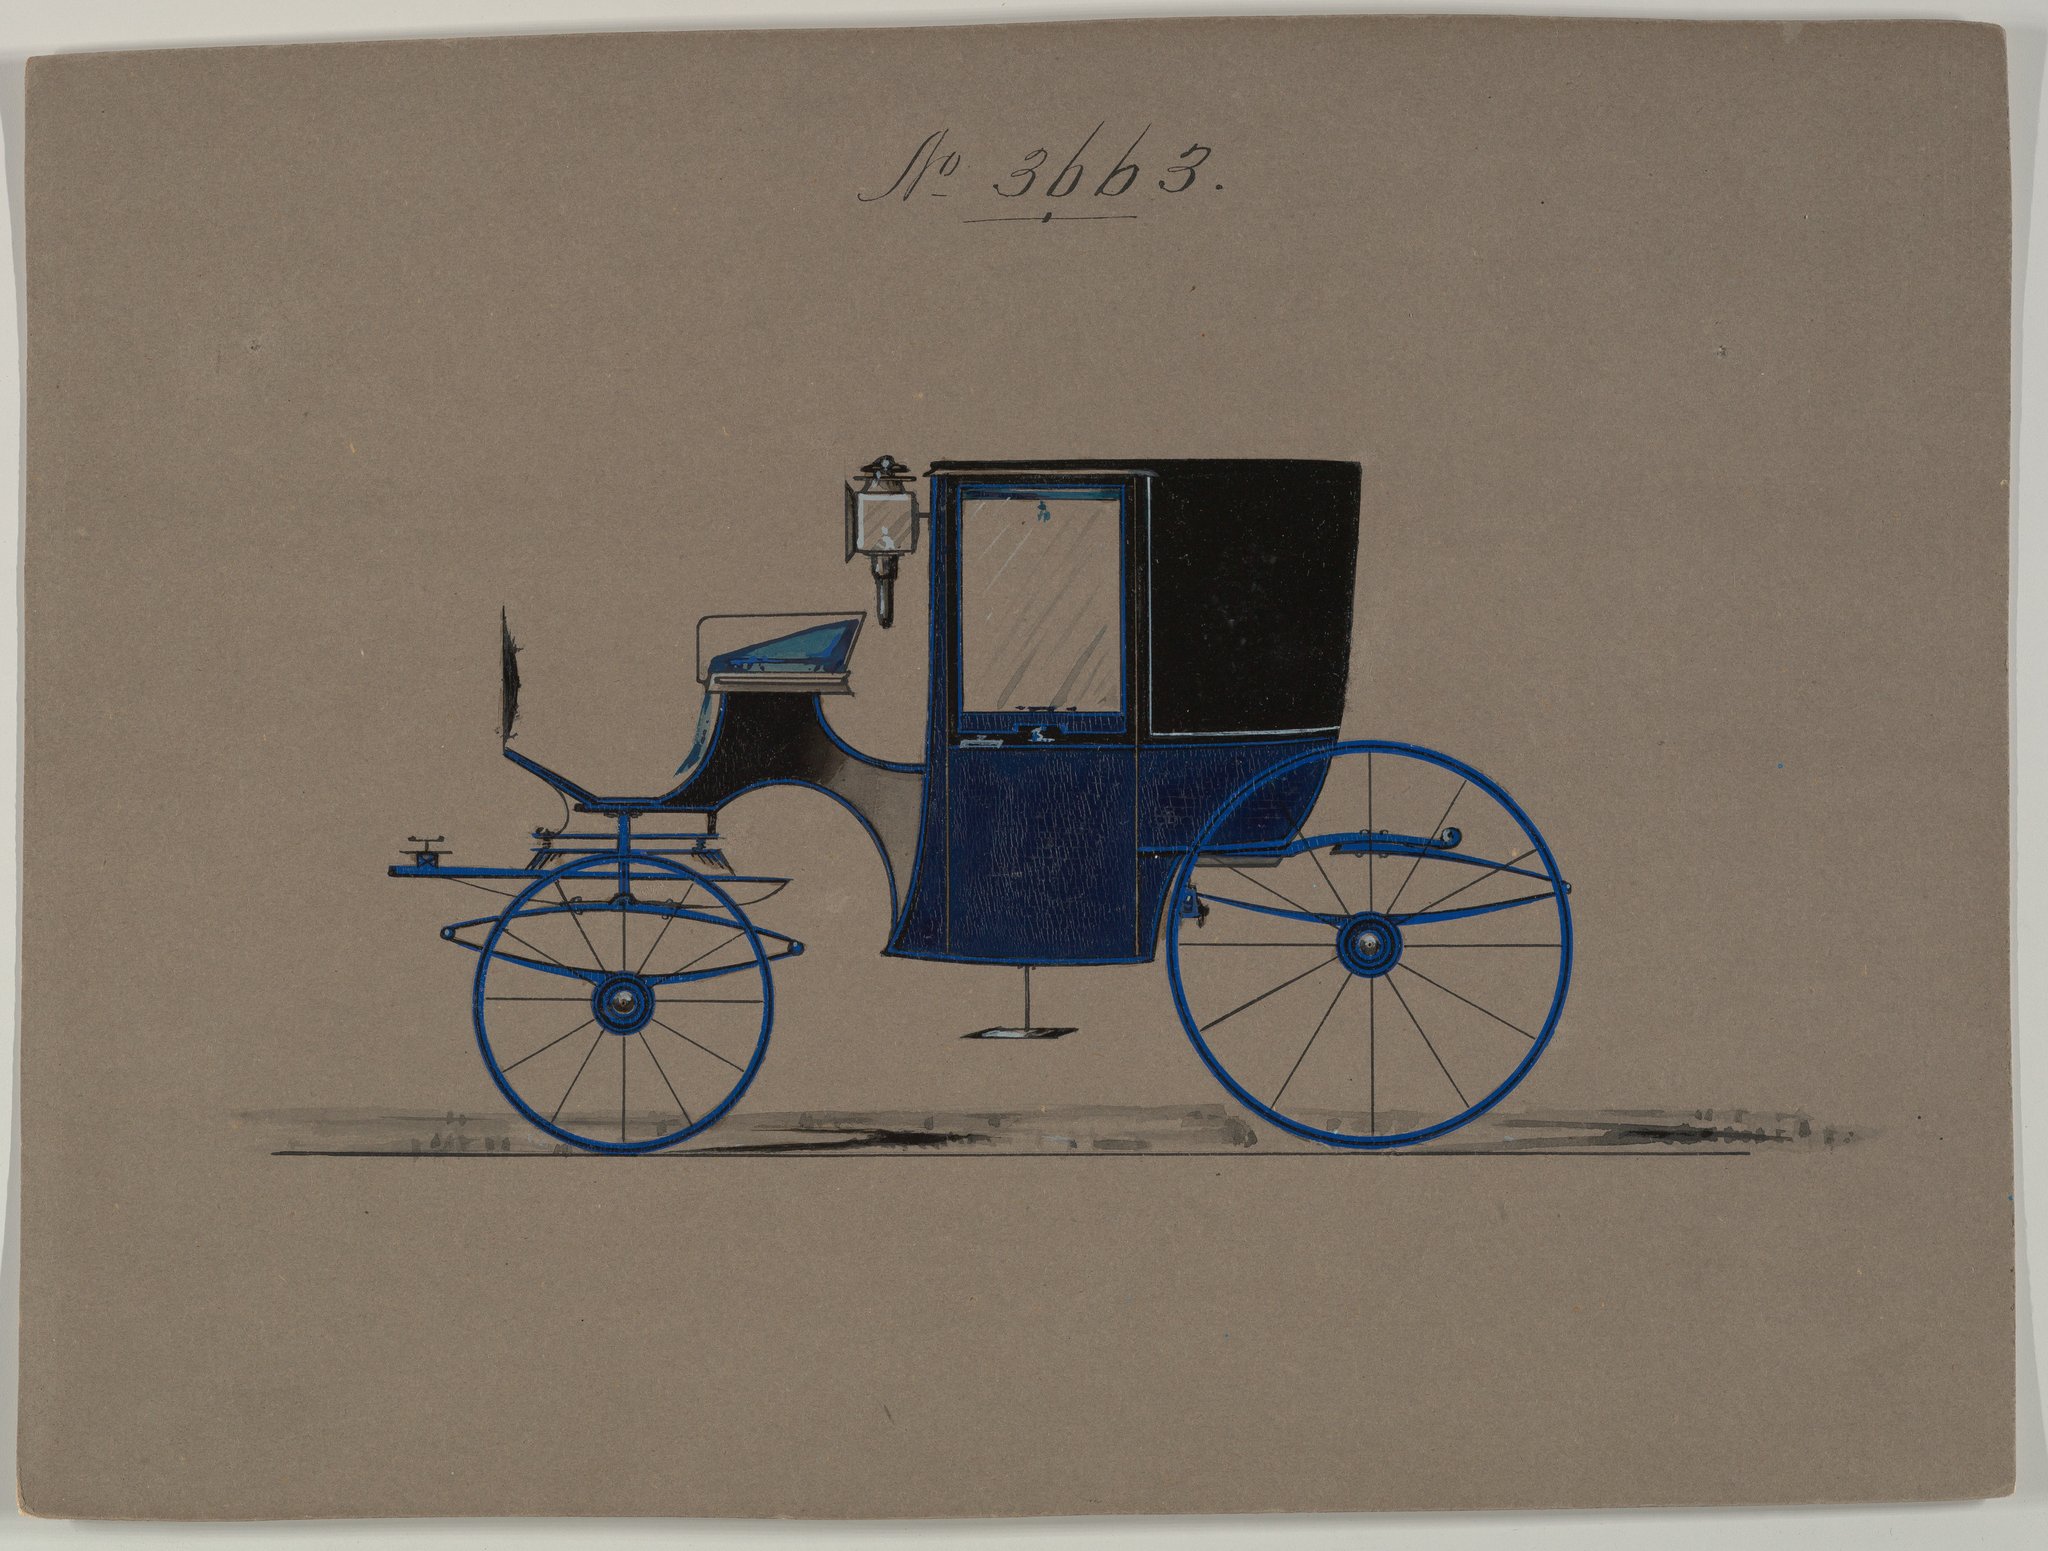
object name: drawing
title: Brougham #3663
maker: brewster & co.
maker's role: manufacturer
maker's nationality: american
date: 1881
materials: gouache, gum arabic, ink, watercolor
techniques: pen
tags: carriages